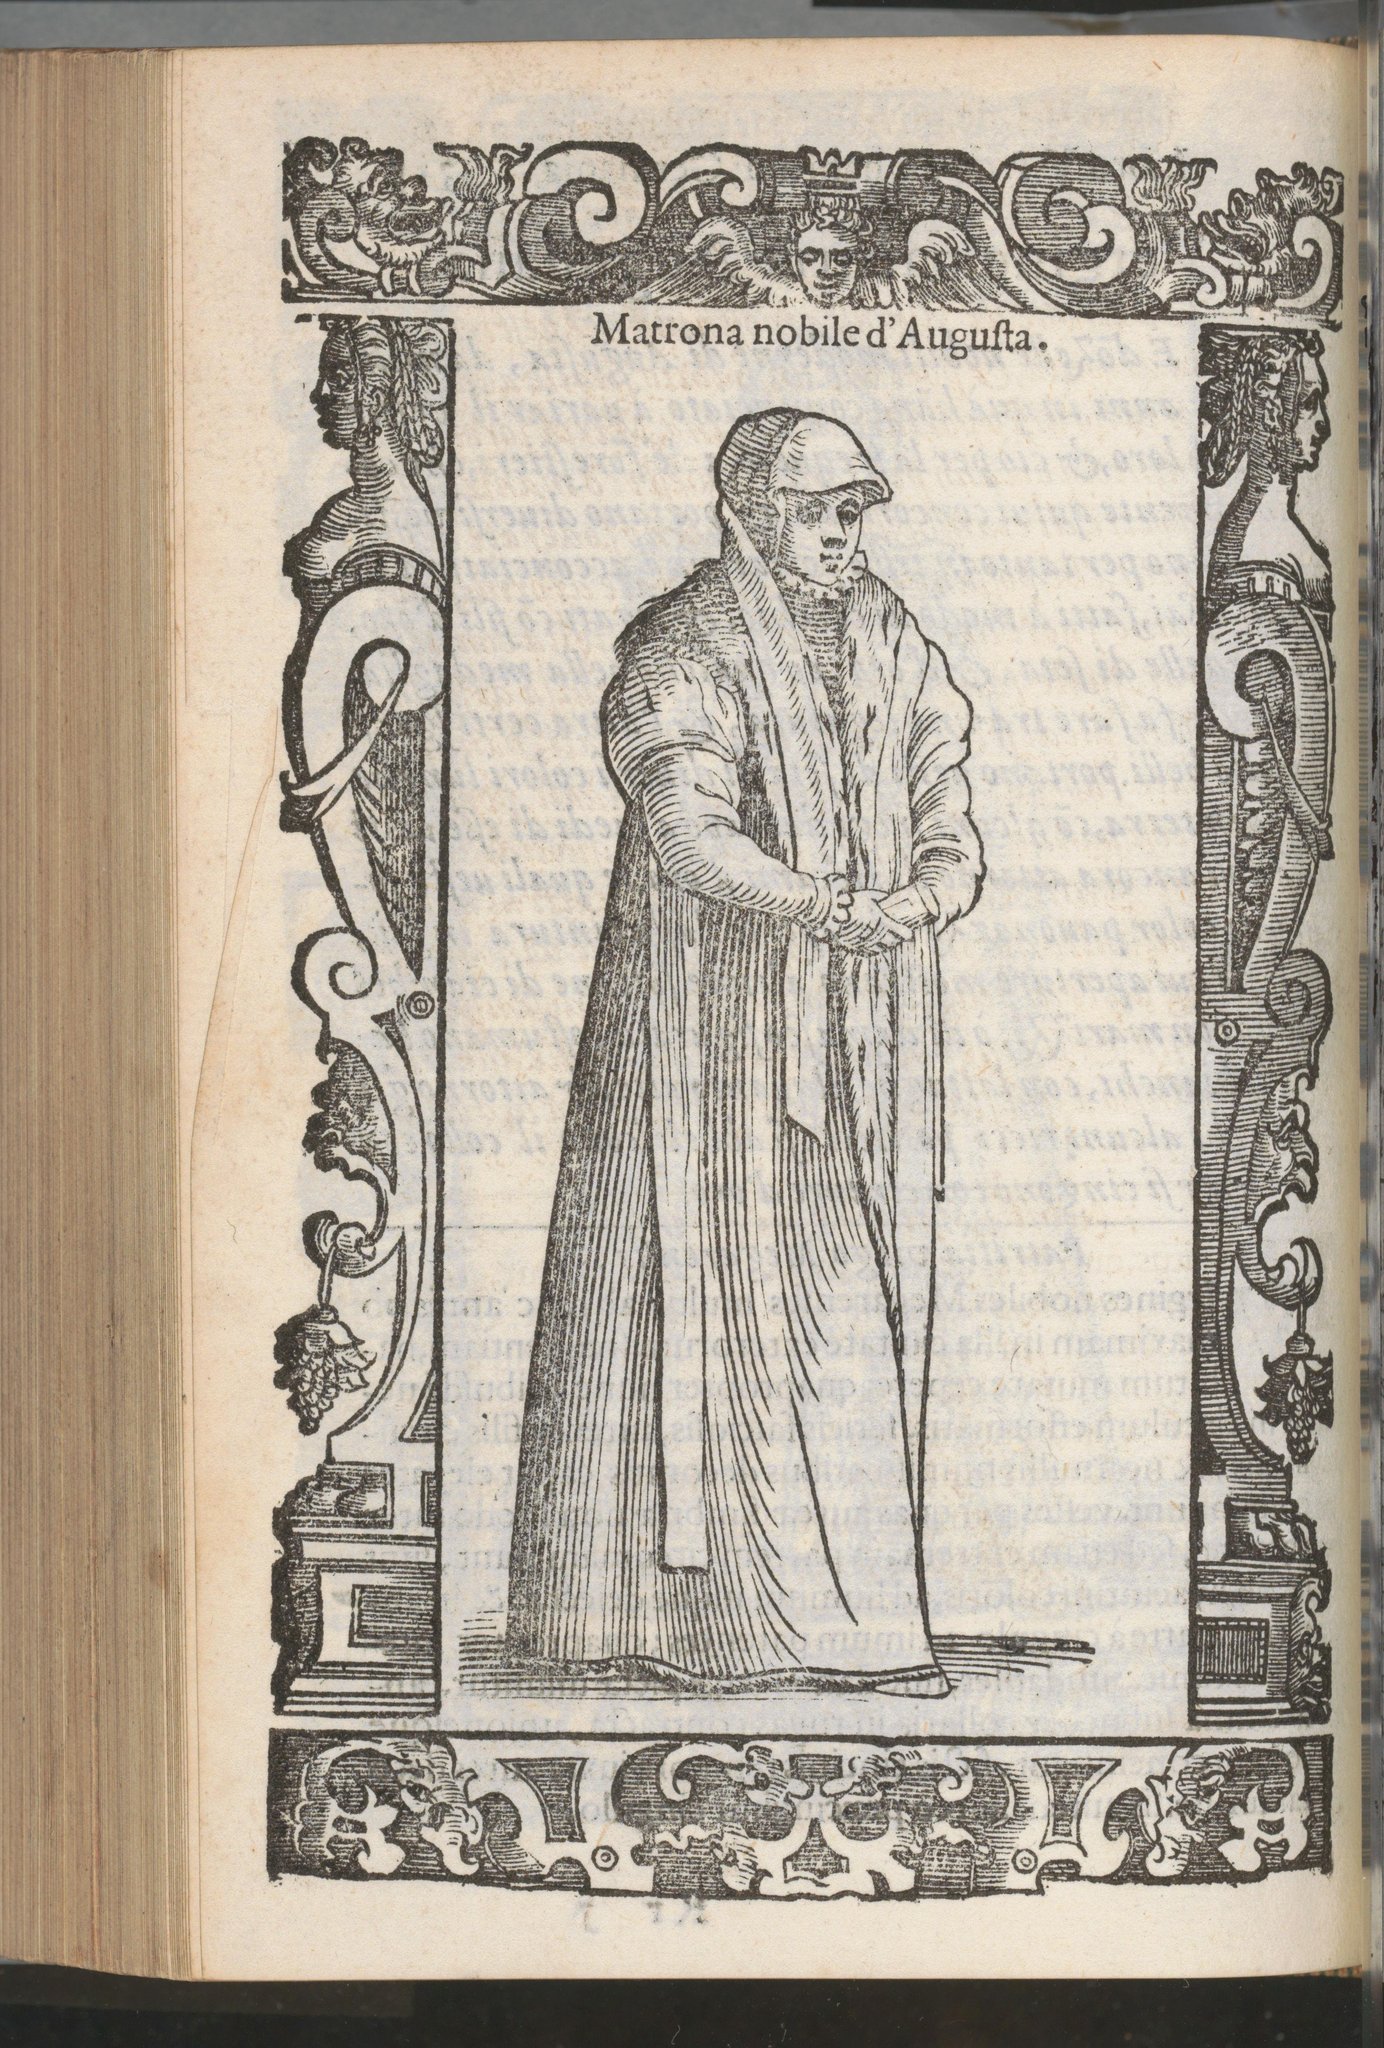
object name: costume print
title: Habiti antichi, et moderni di tutto il mondo...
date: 1598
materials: paper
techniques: woodcut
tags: fashion plates